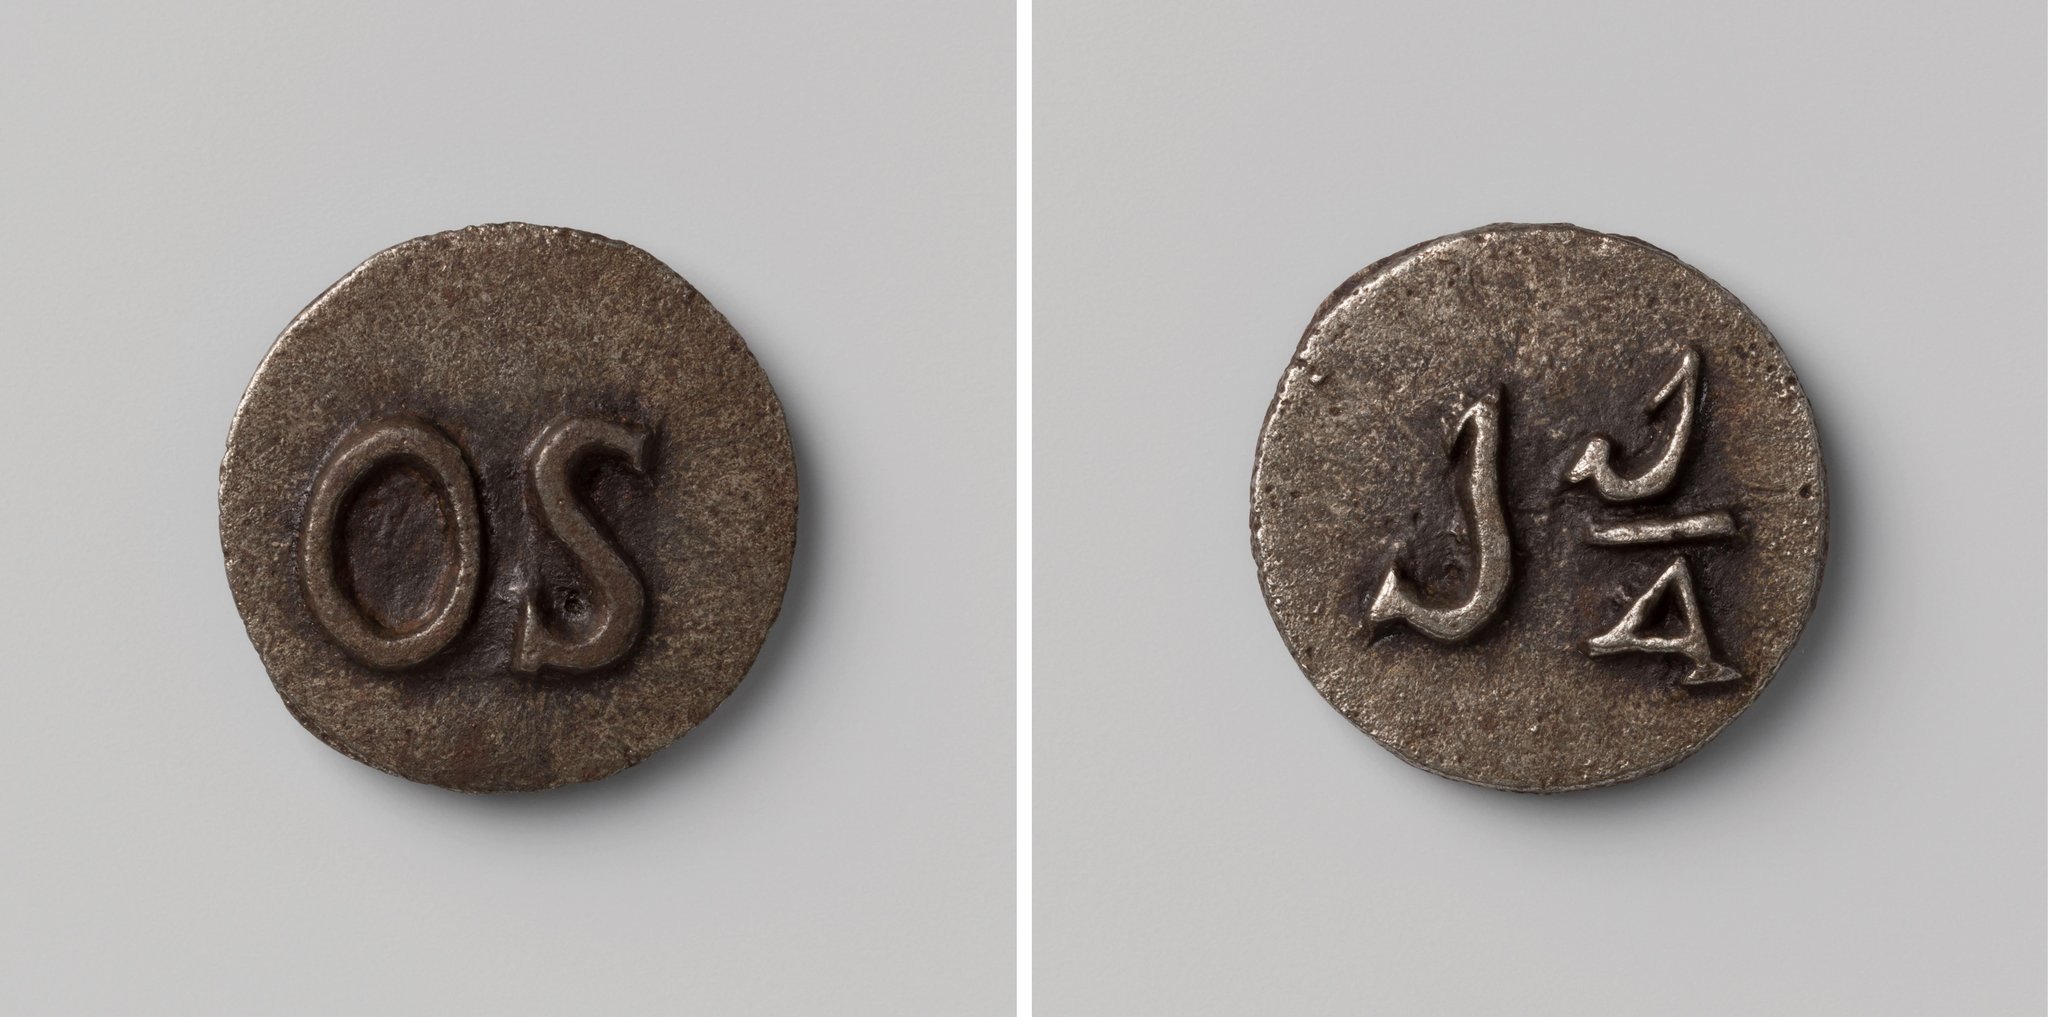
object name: een en een kwart cent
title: Strafgevangenis Ommerschans, huismunt geslagen op last van de Maatschappij van Weldadigheid ter waarde van 1¼ cent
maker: Anonymous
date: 1818-1859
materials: iron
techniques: casting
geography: netherlands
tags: maatschappij van weldadigheid, ommerschans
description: Voorzijde: letters O en S. Keerzijde: cijfer 1¼